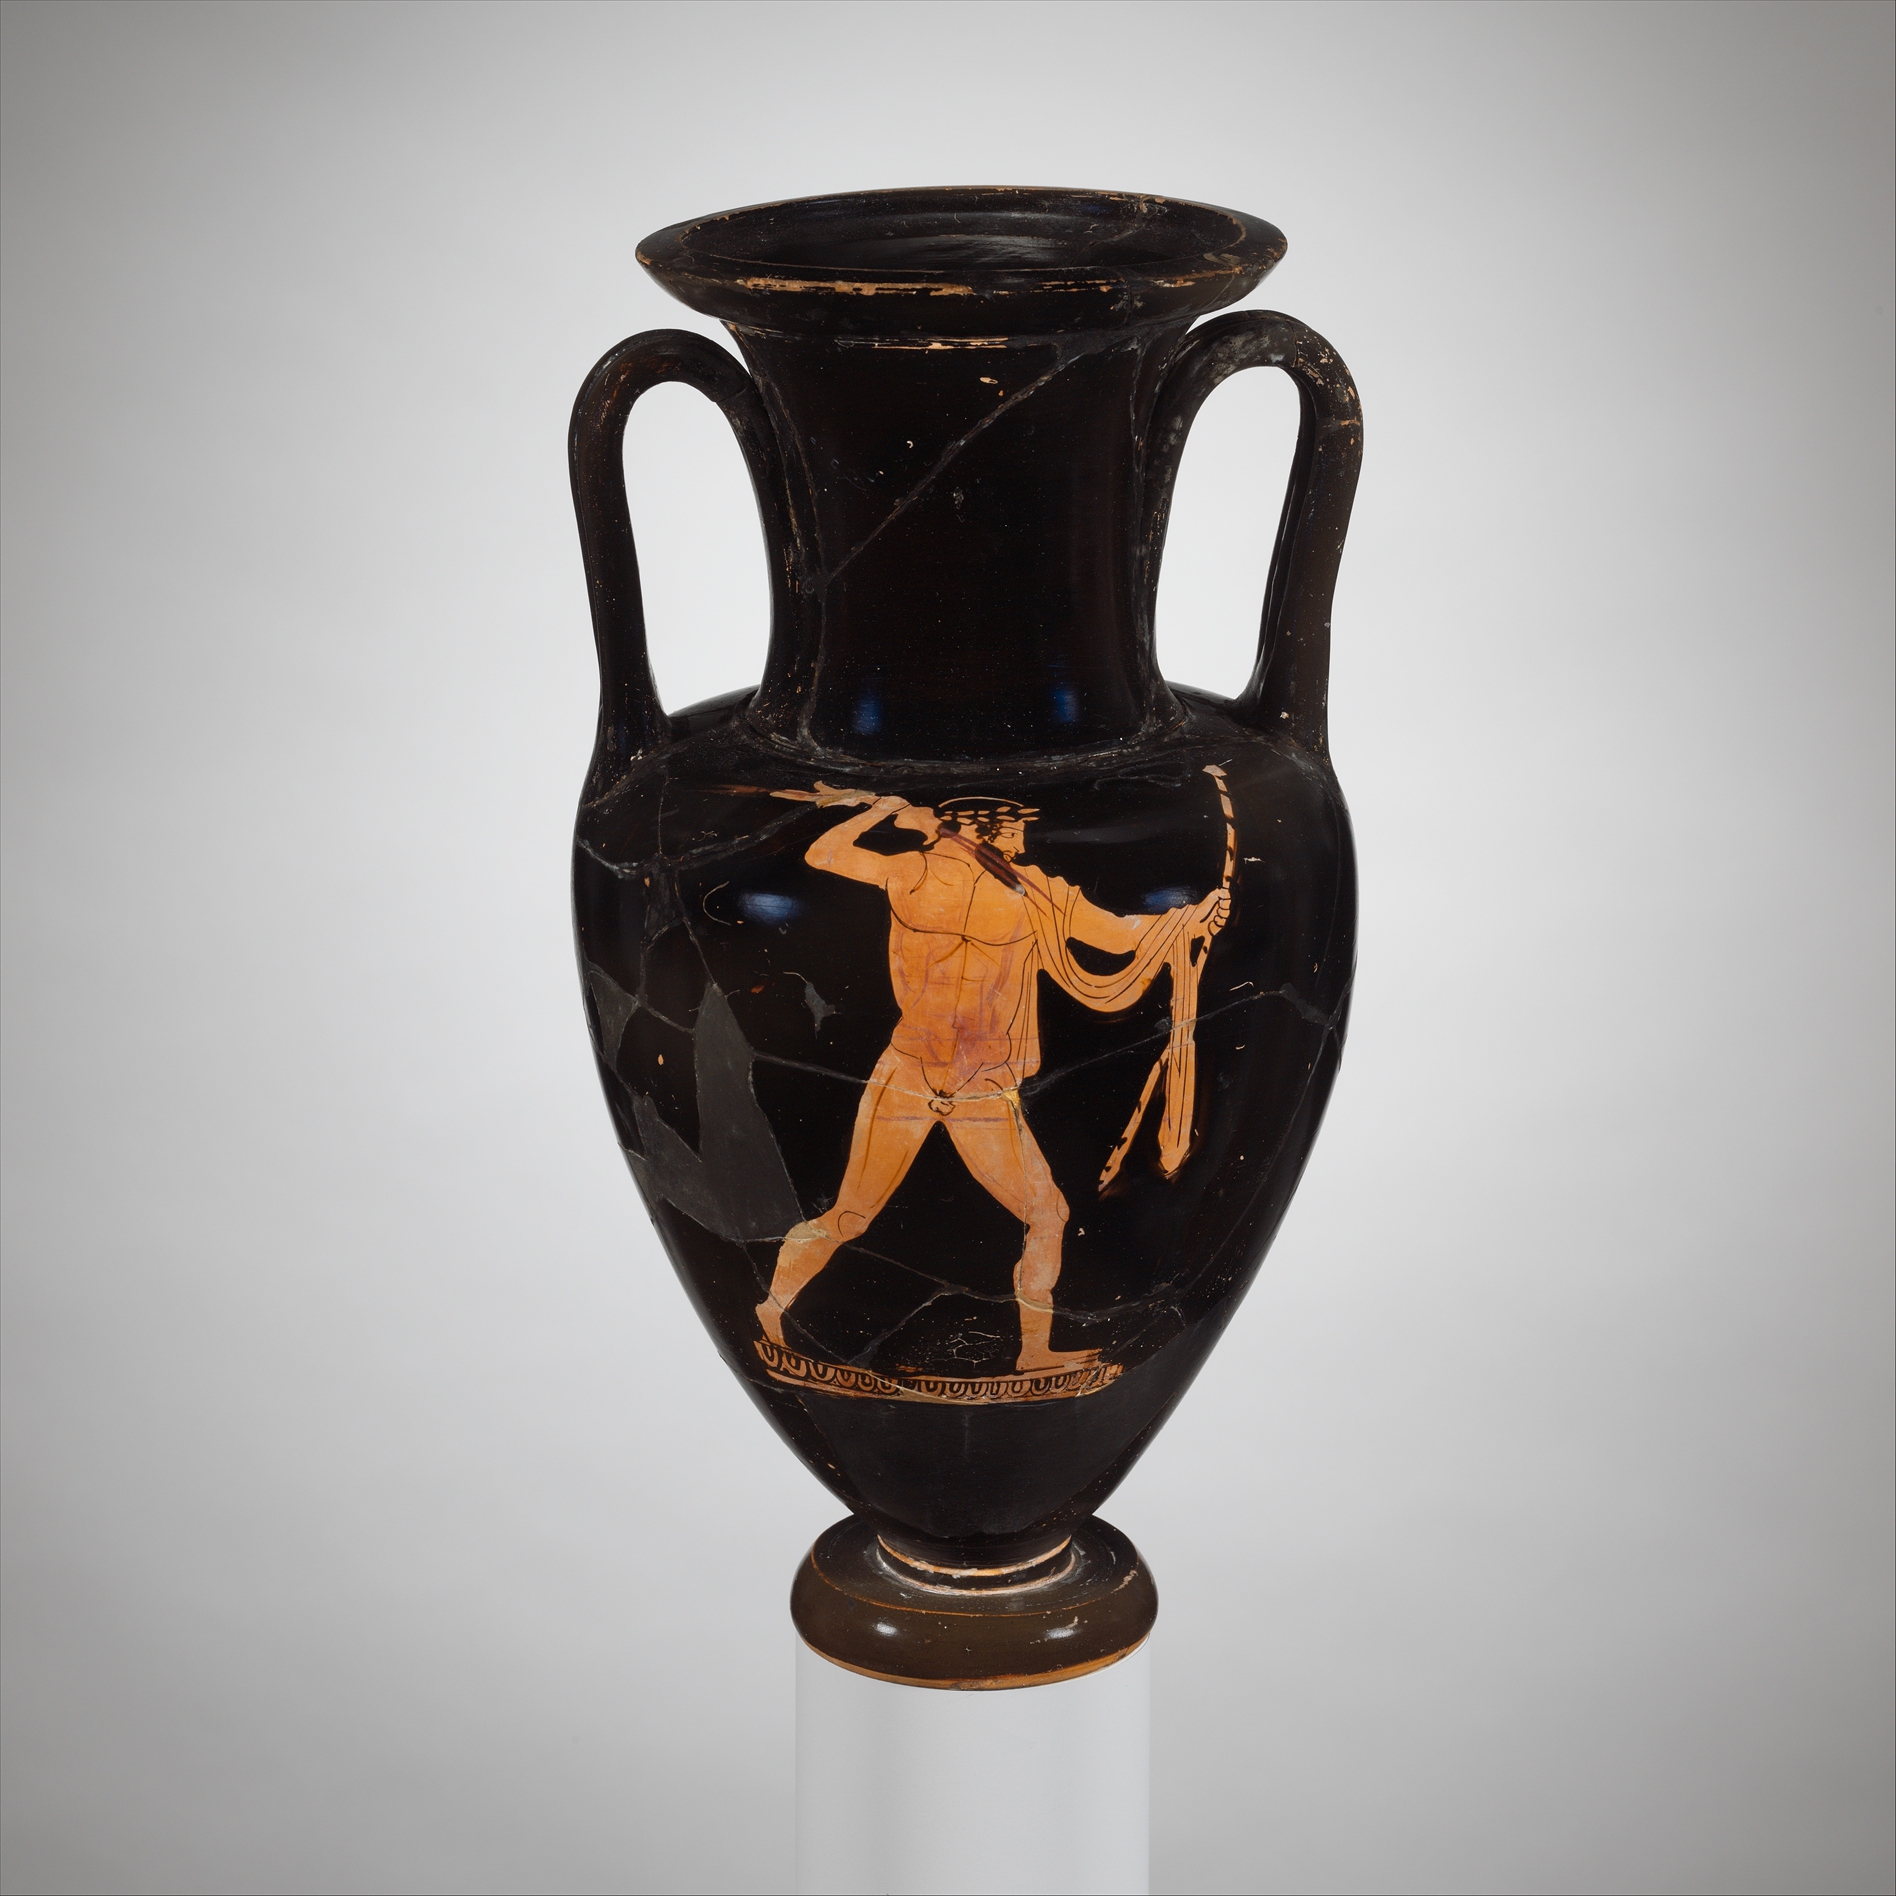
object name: neck amphora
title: Terracotta Nolan neck-amphora (jar)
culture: greek, attic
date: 460-450 BCE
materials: terracotta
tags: bow and arrow,zeus